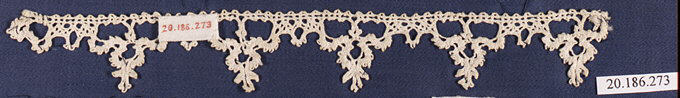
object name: edging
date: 1501-1600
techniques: lace